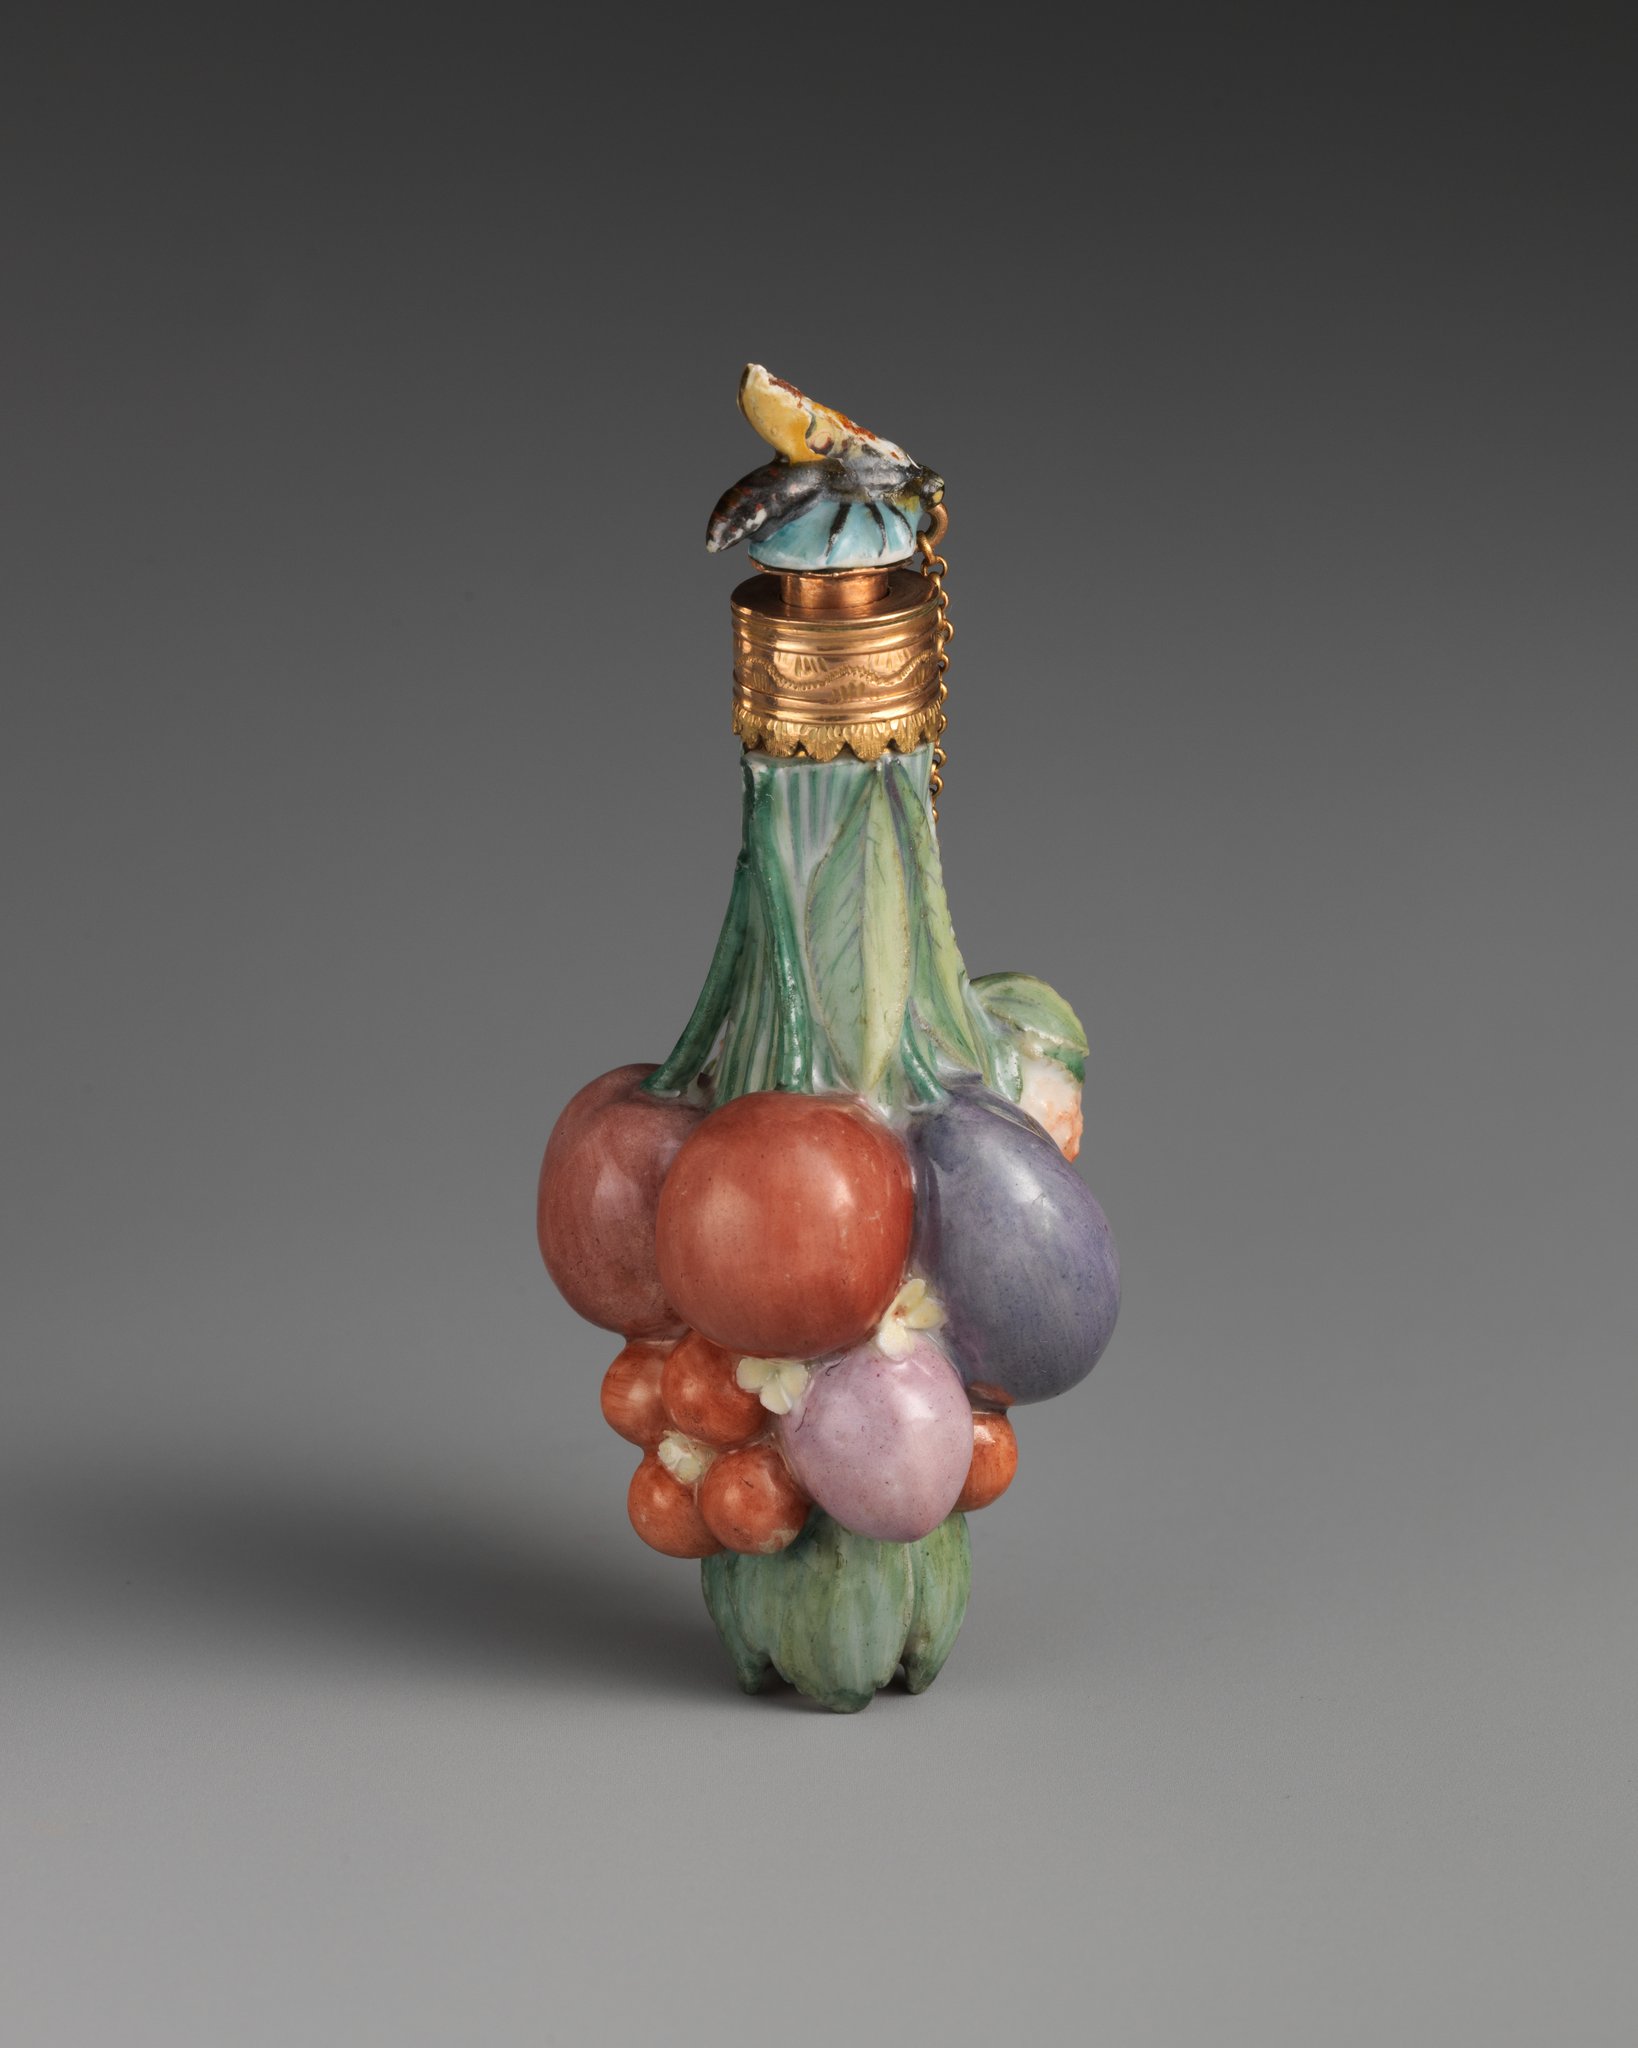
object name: toy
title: Fruit and flowers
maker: chelsea porcelain manufactory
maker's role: factory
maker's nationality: british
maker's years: 1744-1784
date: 1760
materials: soft paste porcelain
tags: fruit,flowers